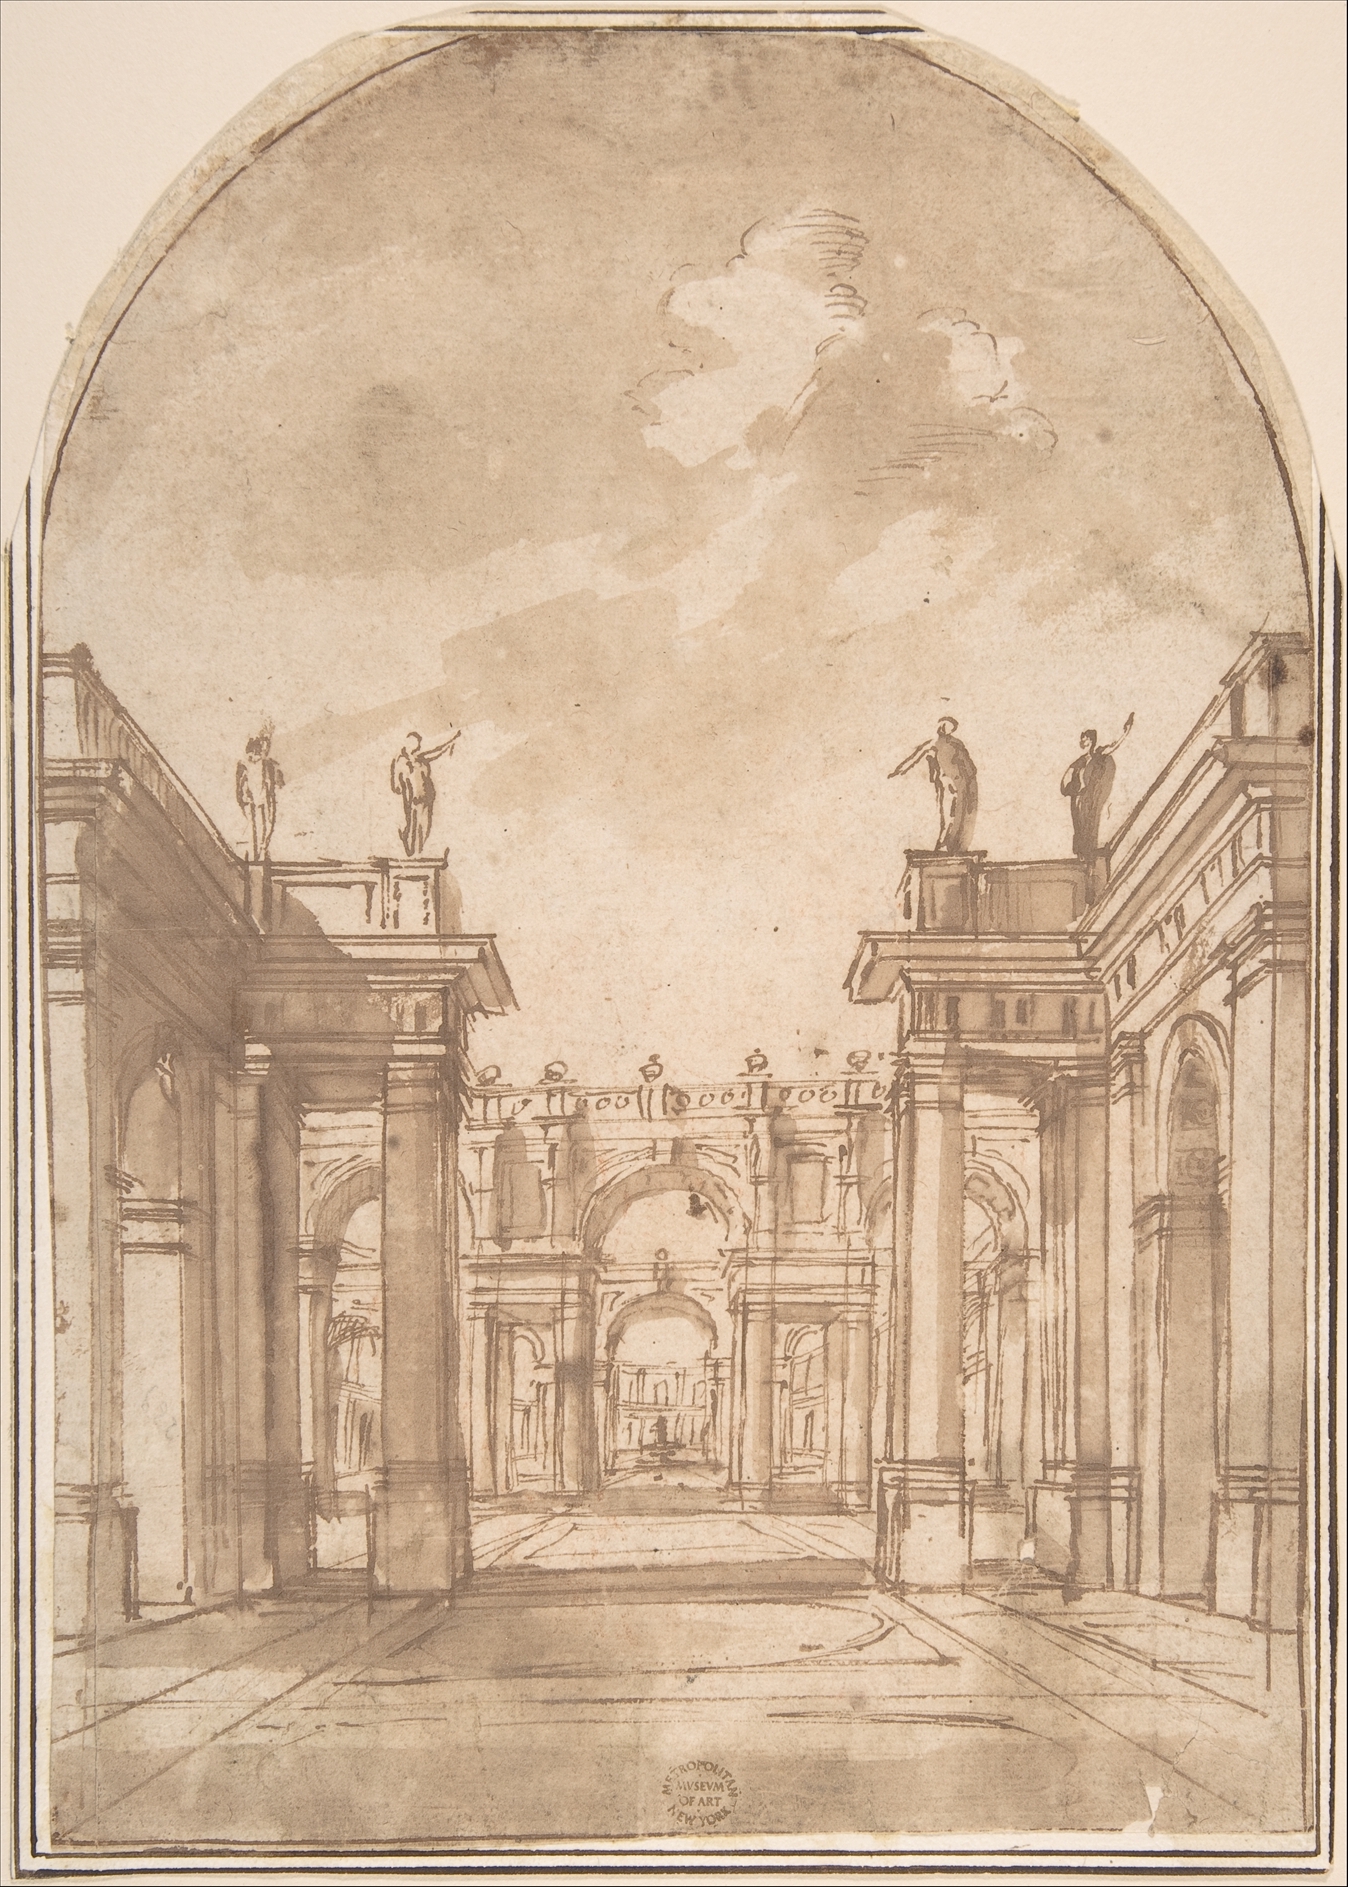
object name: drawing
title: Court Yards (Sketch for Stage Scene ?)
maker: anonymous, italian, 16th century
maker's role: artist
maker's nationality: italian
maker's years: 1550-1600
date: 1501-1600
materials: ink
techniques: brush, pen, wash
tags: courtyards